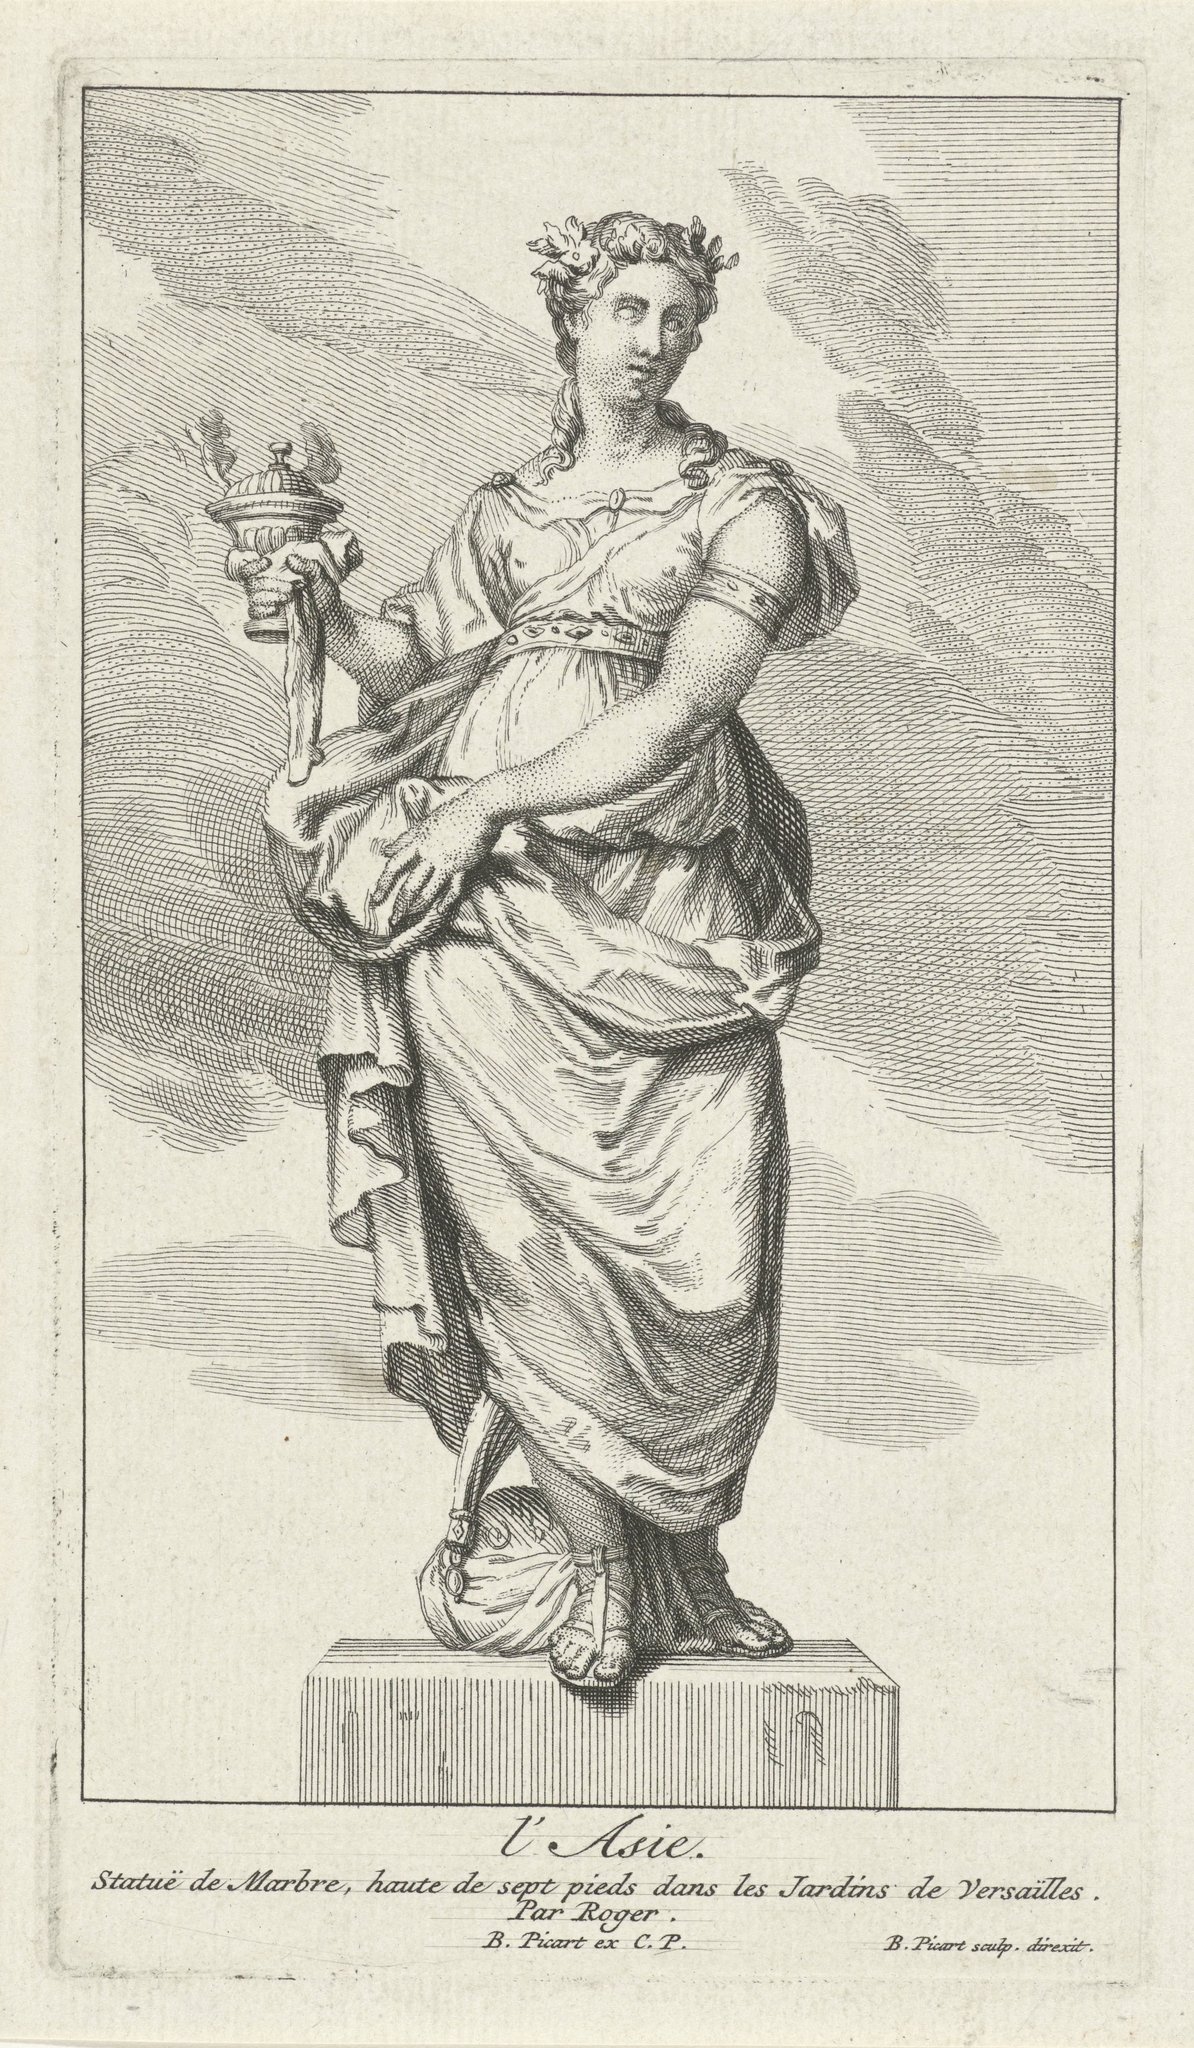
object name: print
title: Standbeelden uit de tuinen van Versailles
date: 1709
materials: paper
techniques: engraving, etching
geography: paris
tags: asia represented allegorically; 'asia' (ripa), piece of sculpture, reproduction of a piece of sculpture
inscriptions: collector's mark: Lugt 240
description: Standbeeld in de tuinen van Versailles. De vrouwelijke personificatie van Azië, gekroond met een bloemenkrans, een wierookvat in de hand. Aan haar voeten een tulband. In de marge een onderschrift in het Frans.